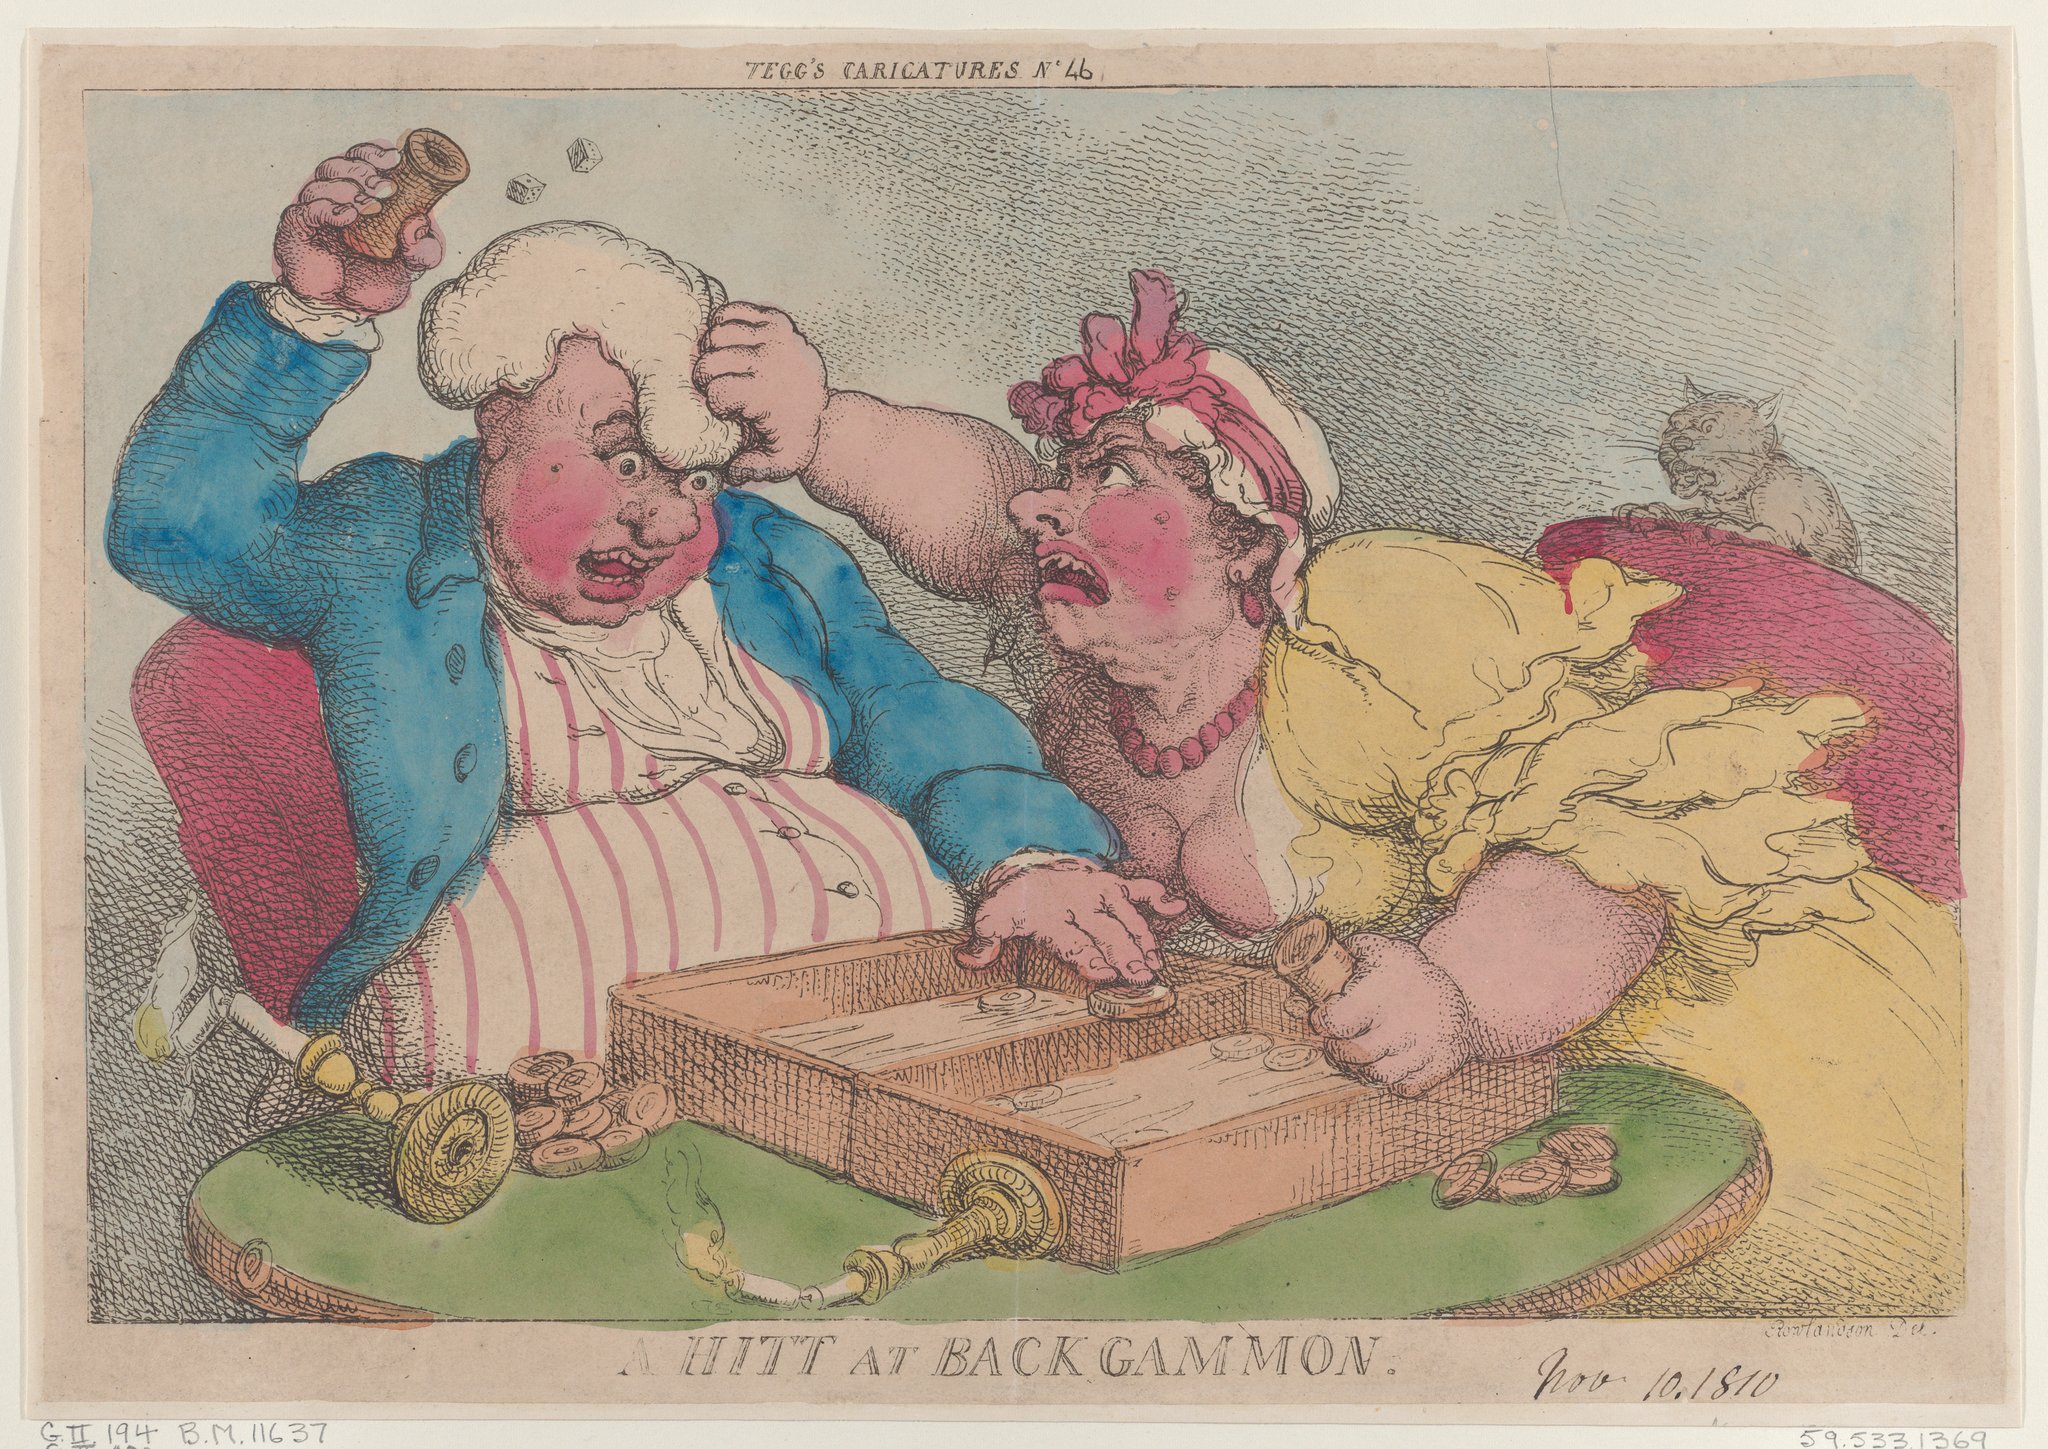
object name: print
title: A Hitt at Backgammon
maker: thomas rowlandson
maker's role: artist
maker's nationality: british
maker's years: 1757-1827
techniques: etching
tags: satire,men,women,cats,games